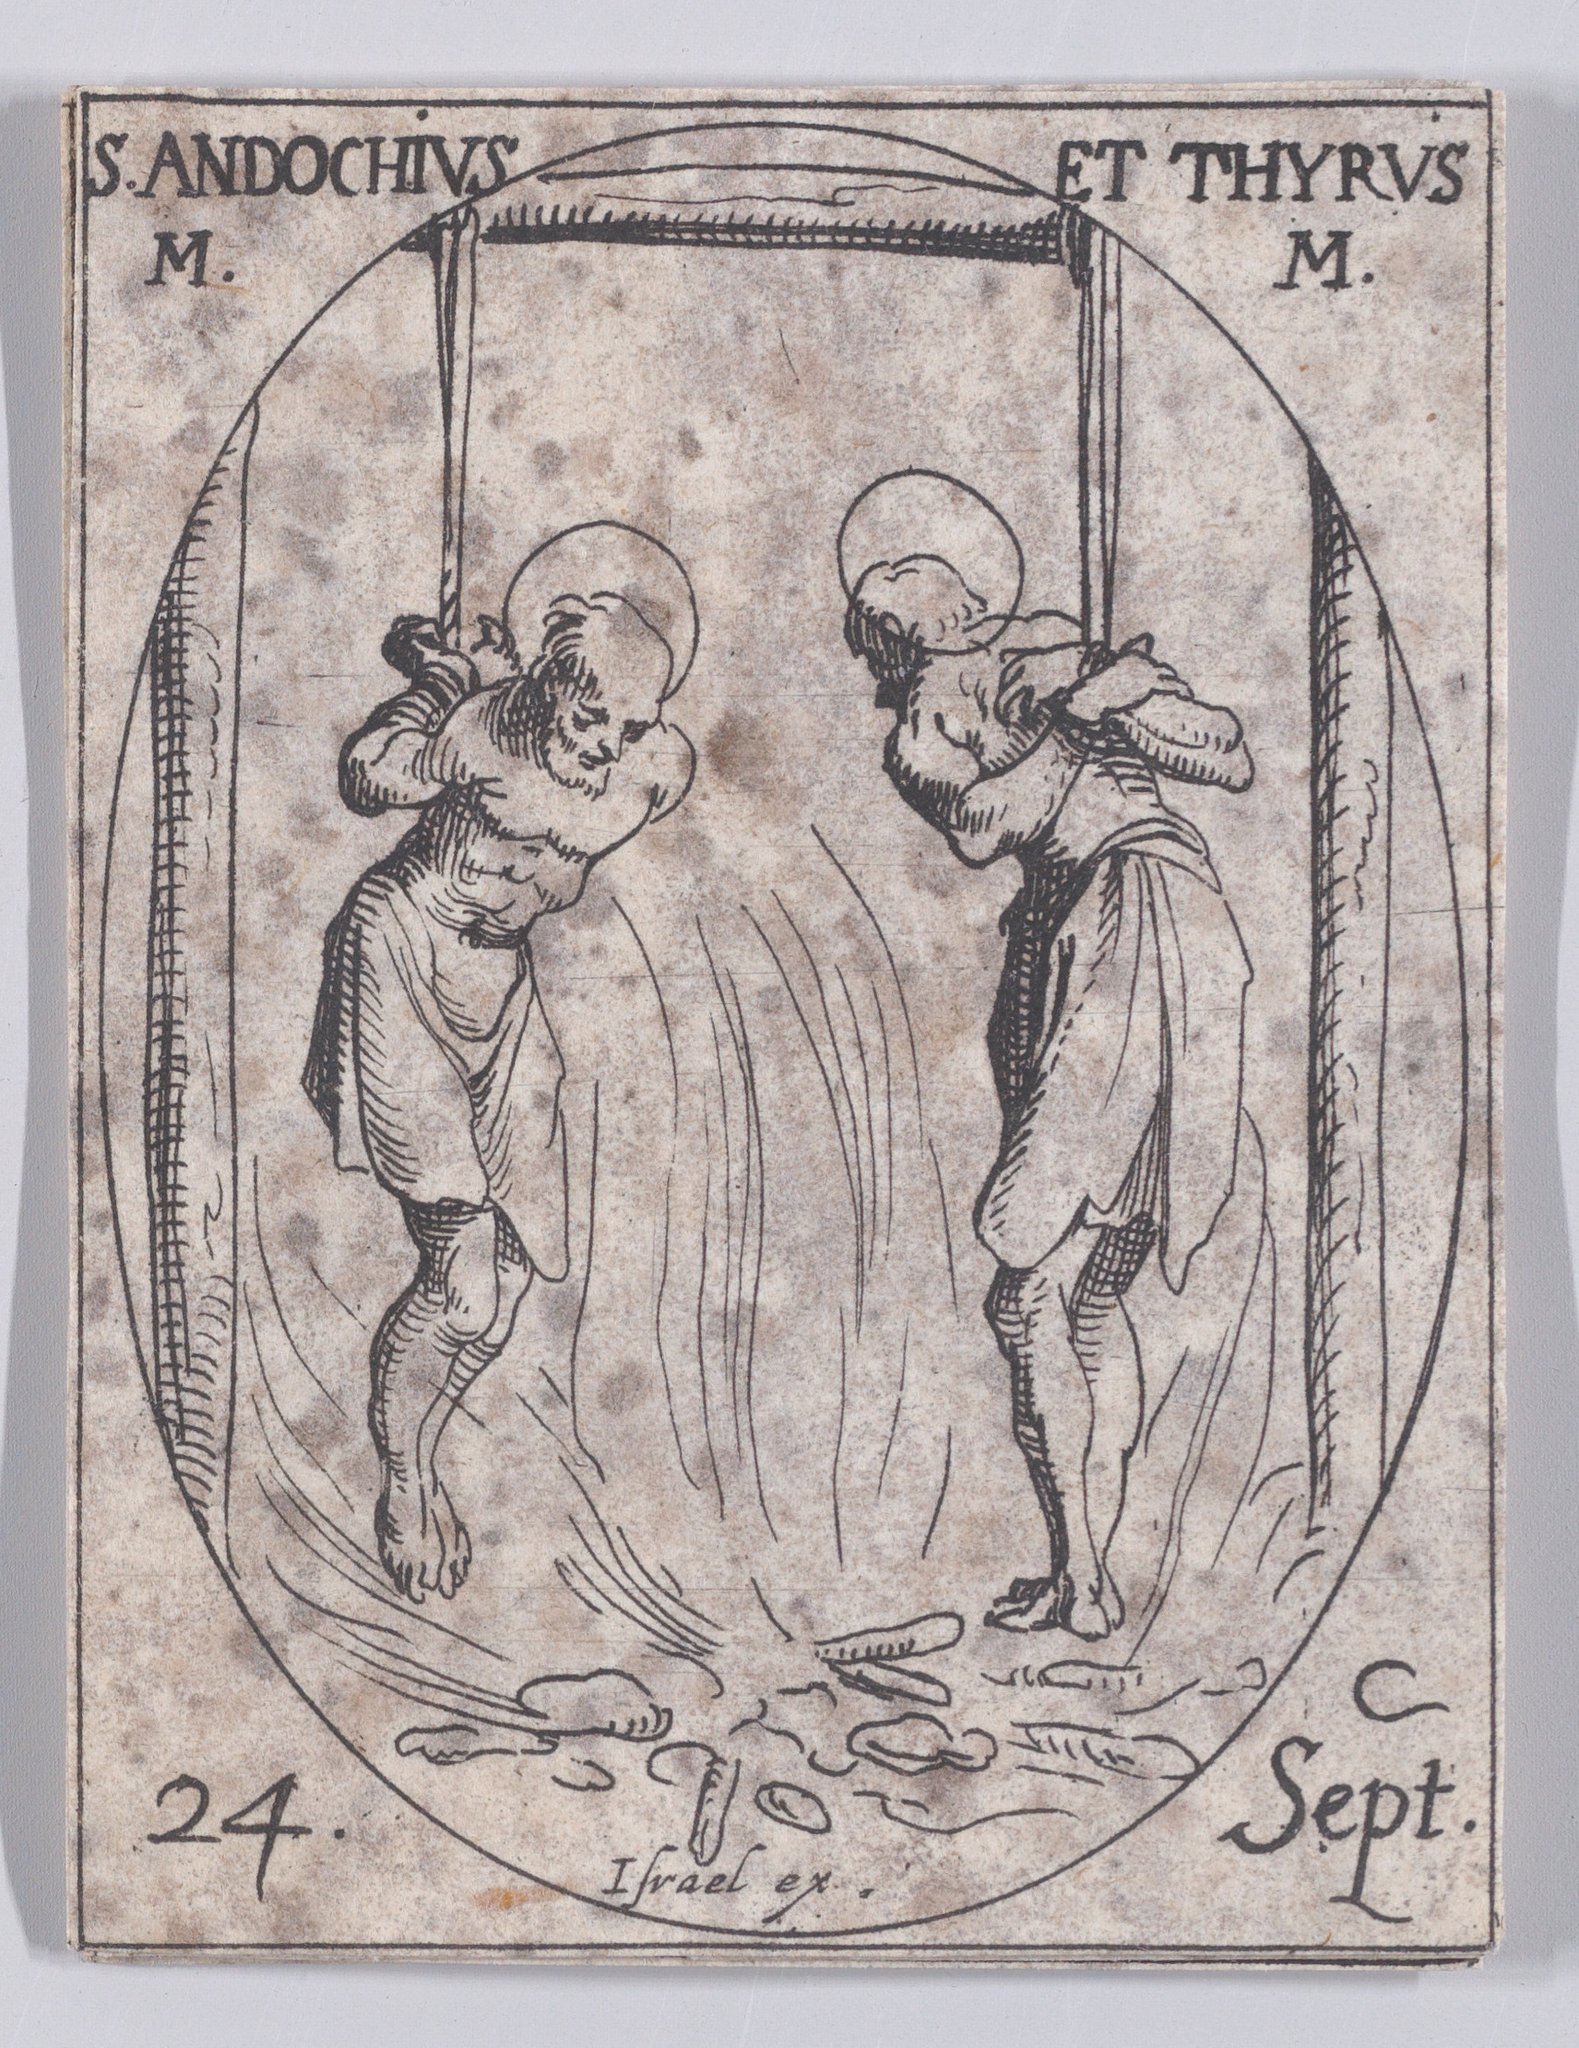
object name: print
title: S. Andoche et S. Tyrse, martyrs (St. Andochius and Thyrsus, Martyrs), September 24th, from "Les Images De Tous Les Saincts et Saintes de L'Année" (Images of All of the Saints and Religious Events of the Year)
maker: jacques callot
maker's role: artist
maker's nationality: french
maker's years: 1592-1635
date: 1636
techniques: etching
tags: men,saints